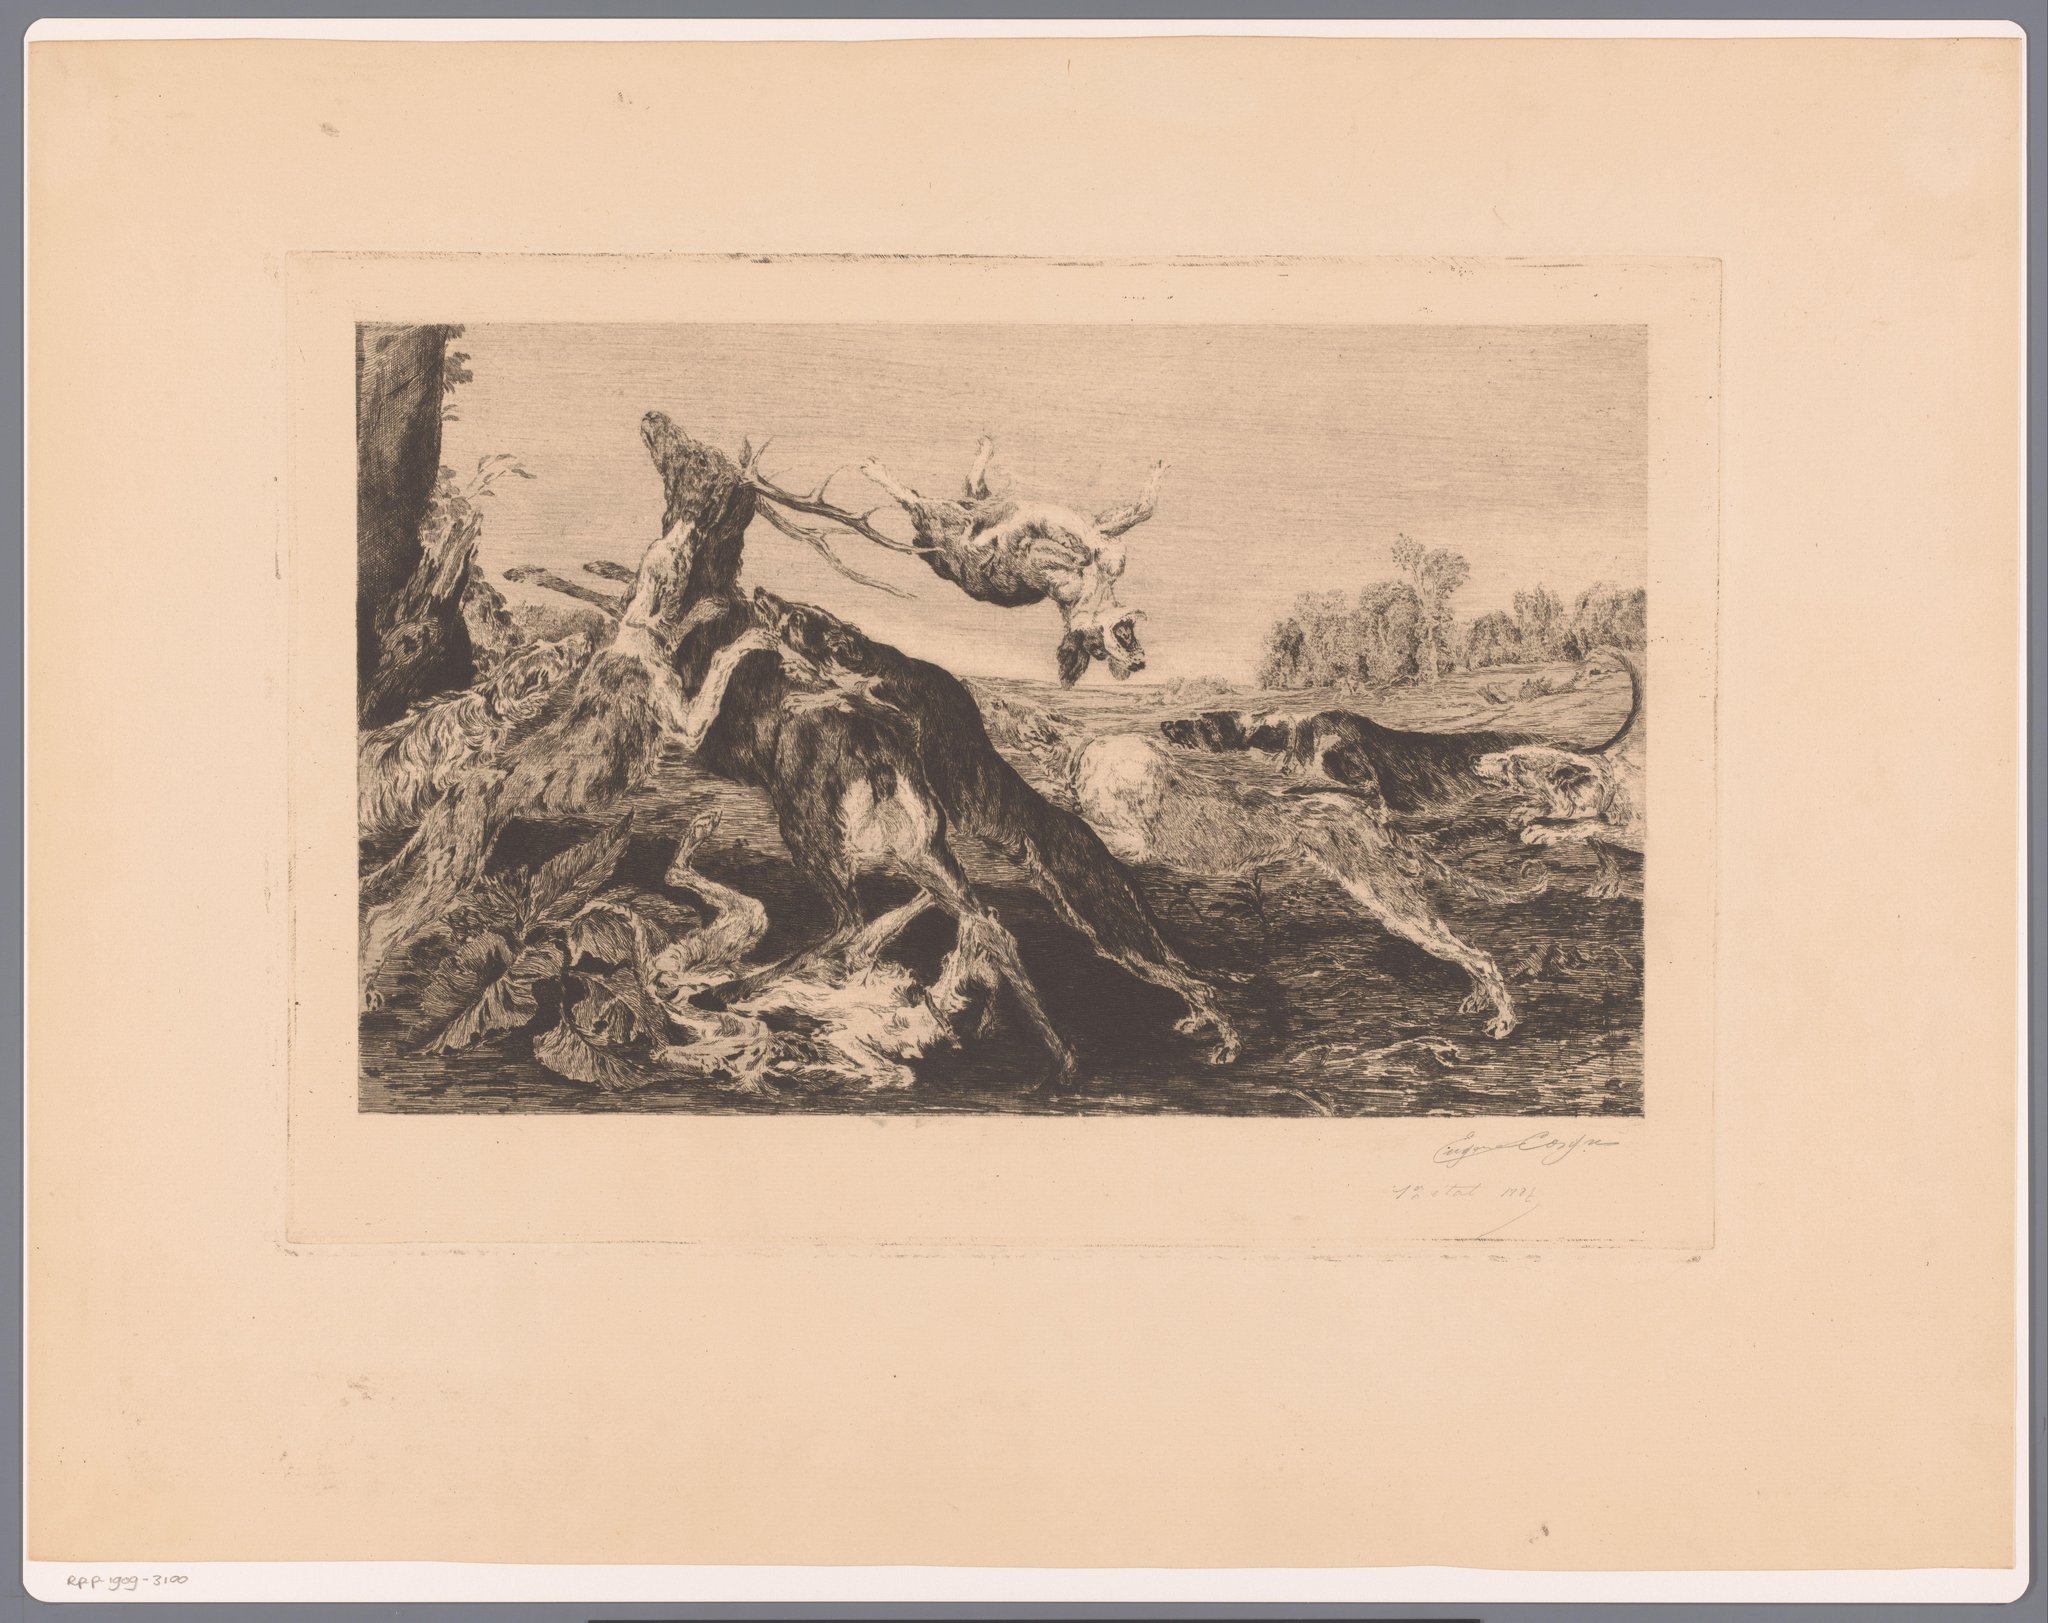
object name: print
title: Jachthonden grijpen een hert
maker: eugène cosyns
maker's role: print maker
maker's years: 1862-1909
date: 1887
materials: paper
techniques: etching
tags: hoofed animals: deer, hunting dogs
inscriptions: collector's mark: Lugt 2228, inscription: ‘1em etat 1887’